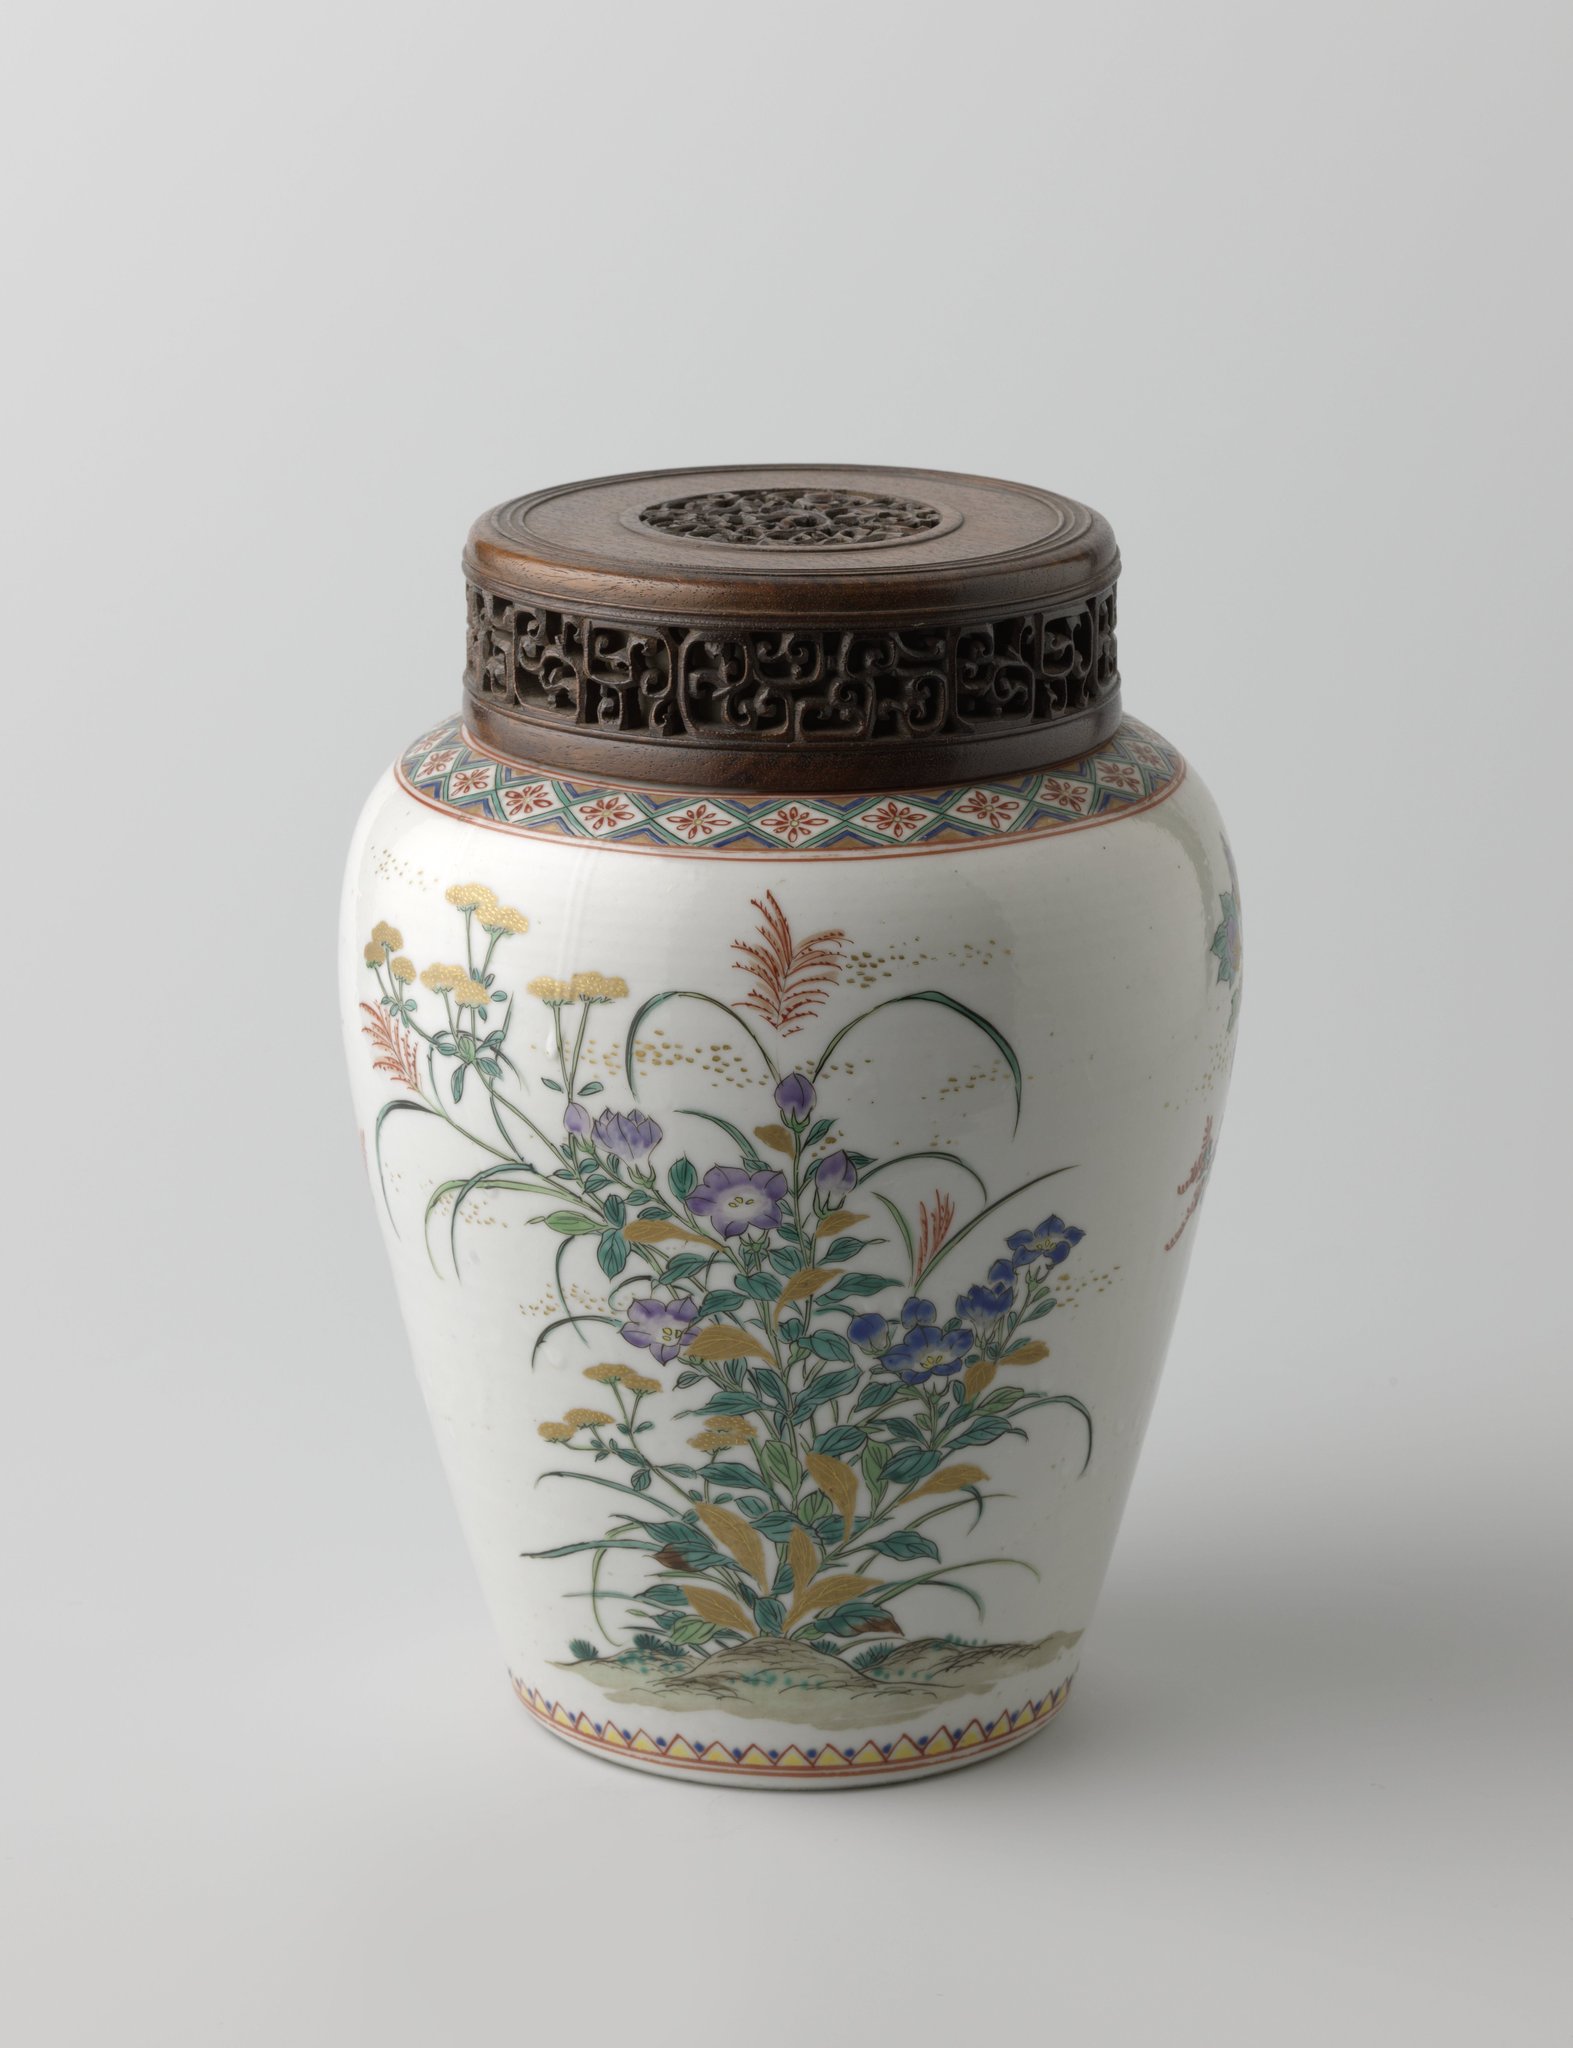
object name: covered jar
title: Jar with two large flower groups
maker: Anonymous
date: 1800-1899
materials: glaze, gold, paint, porcelain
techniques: firing, gilding, turning, vitrification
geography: china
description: Dekselpot van porselein, beschilderd op het glazuur in blauw, rood, groen, geel, paars, roze, zwart en goud. Op de wand een grote bloeiende plant op een rots met pioen en chrysant, aan de andere zijde een tweede bloeiende plant met ballonklokje; rond de voet en de schouder een band met geometrisch patroon. Famille verte.